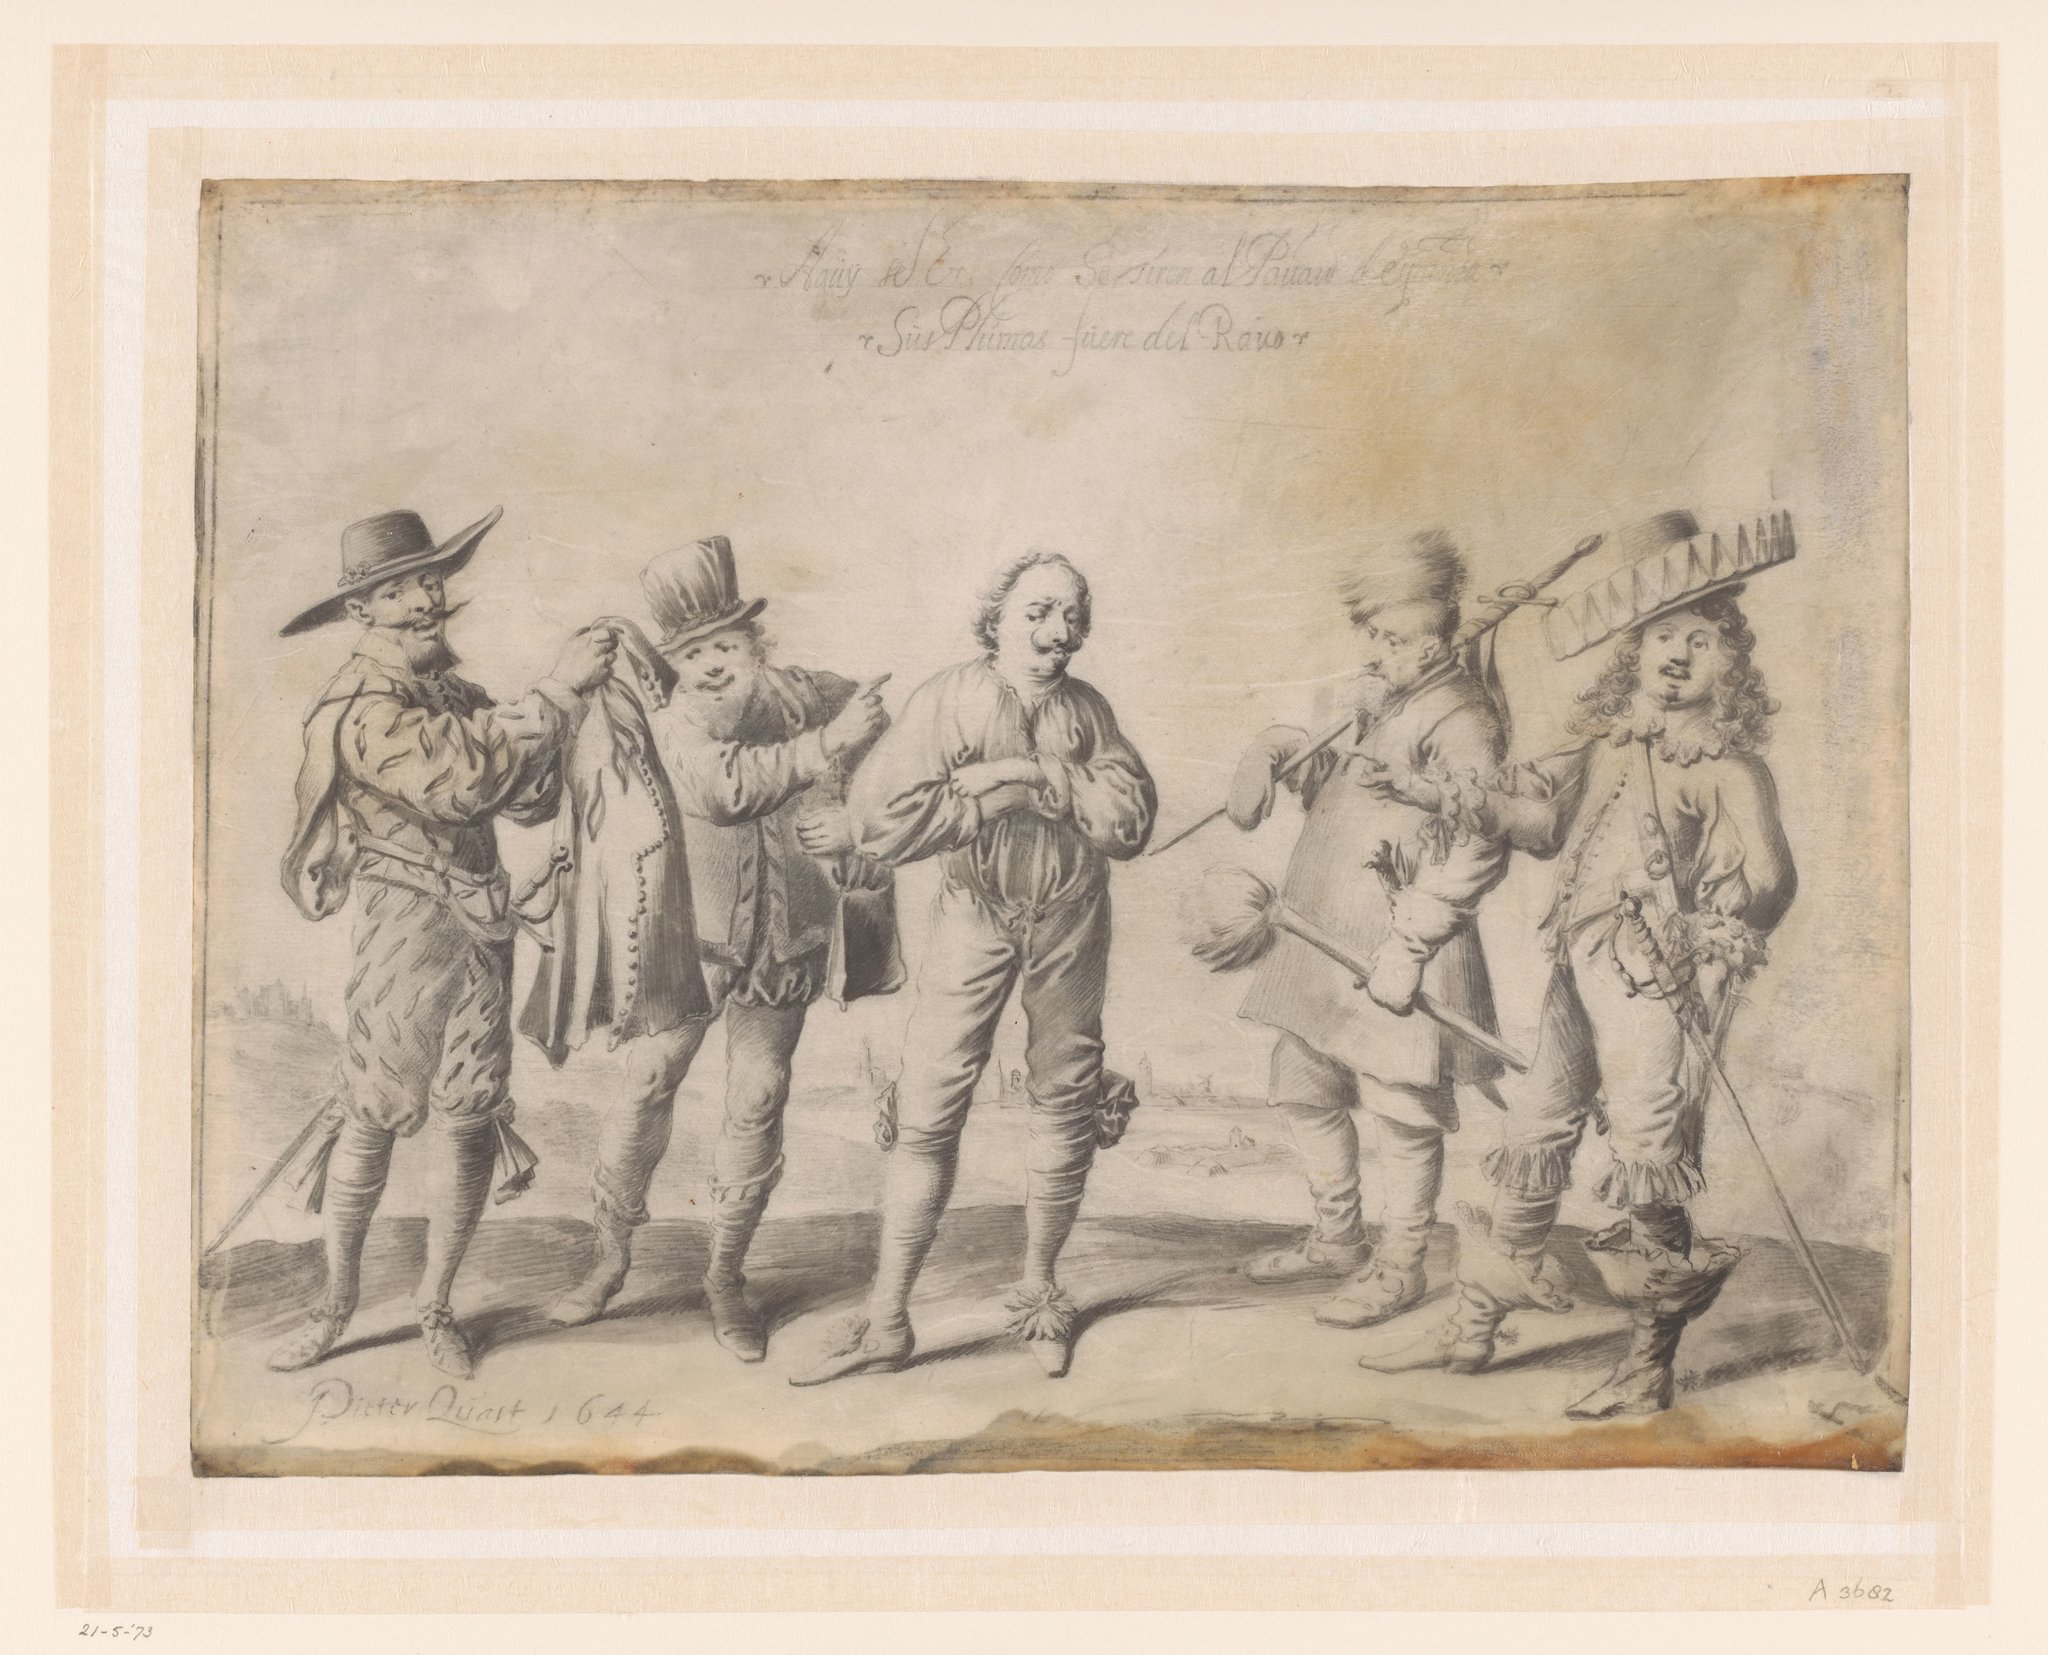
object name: drawing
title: Spotbeeld op de Spanjaard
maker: pieter jansz quast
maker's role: draughtsman, painter, print maker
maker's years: 1605-1647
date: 1644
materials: parchment, pencil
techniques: brush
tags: europeans: spaniards (+ caricatured)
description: Spottekening op de Spanjaard: een Spanjaard staat nu bijna geheel van zijn kleren ontdaan tussen vier personen die hem zijn kleren hebben afgenomen.